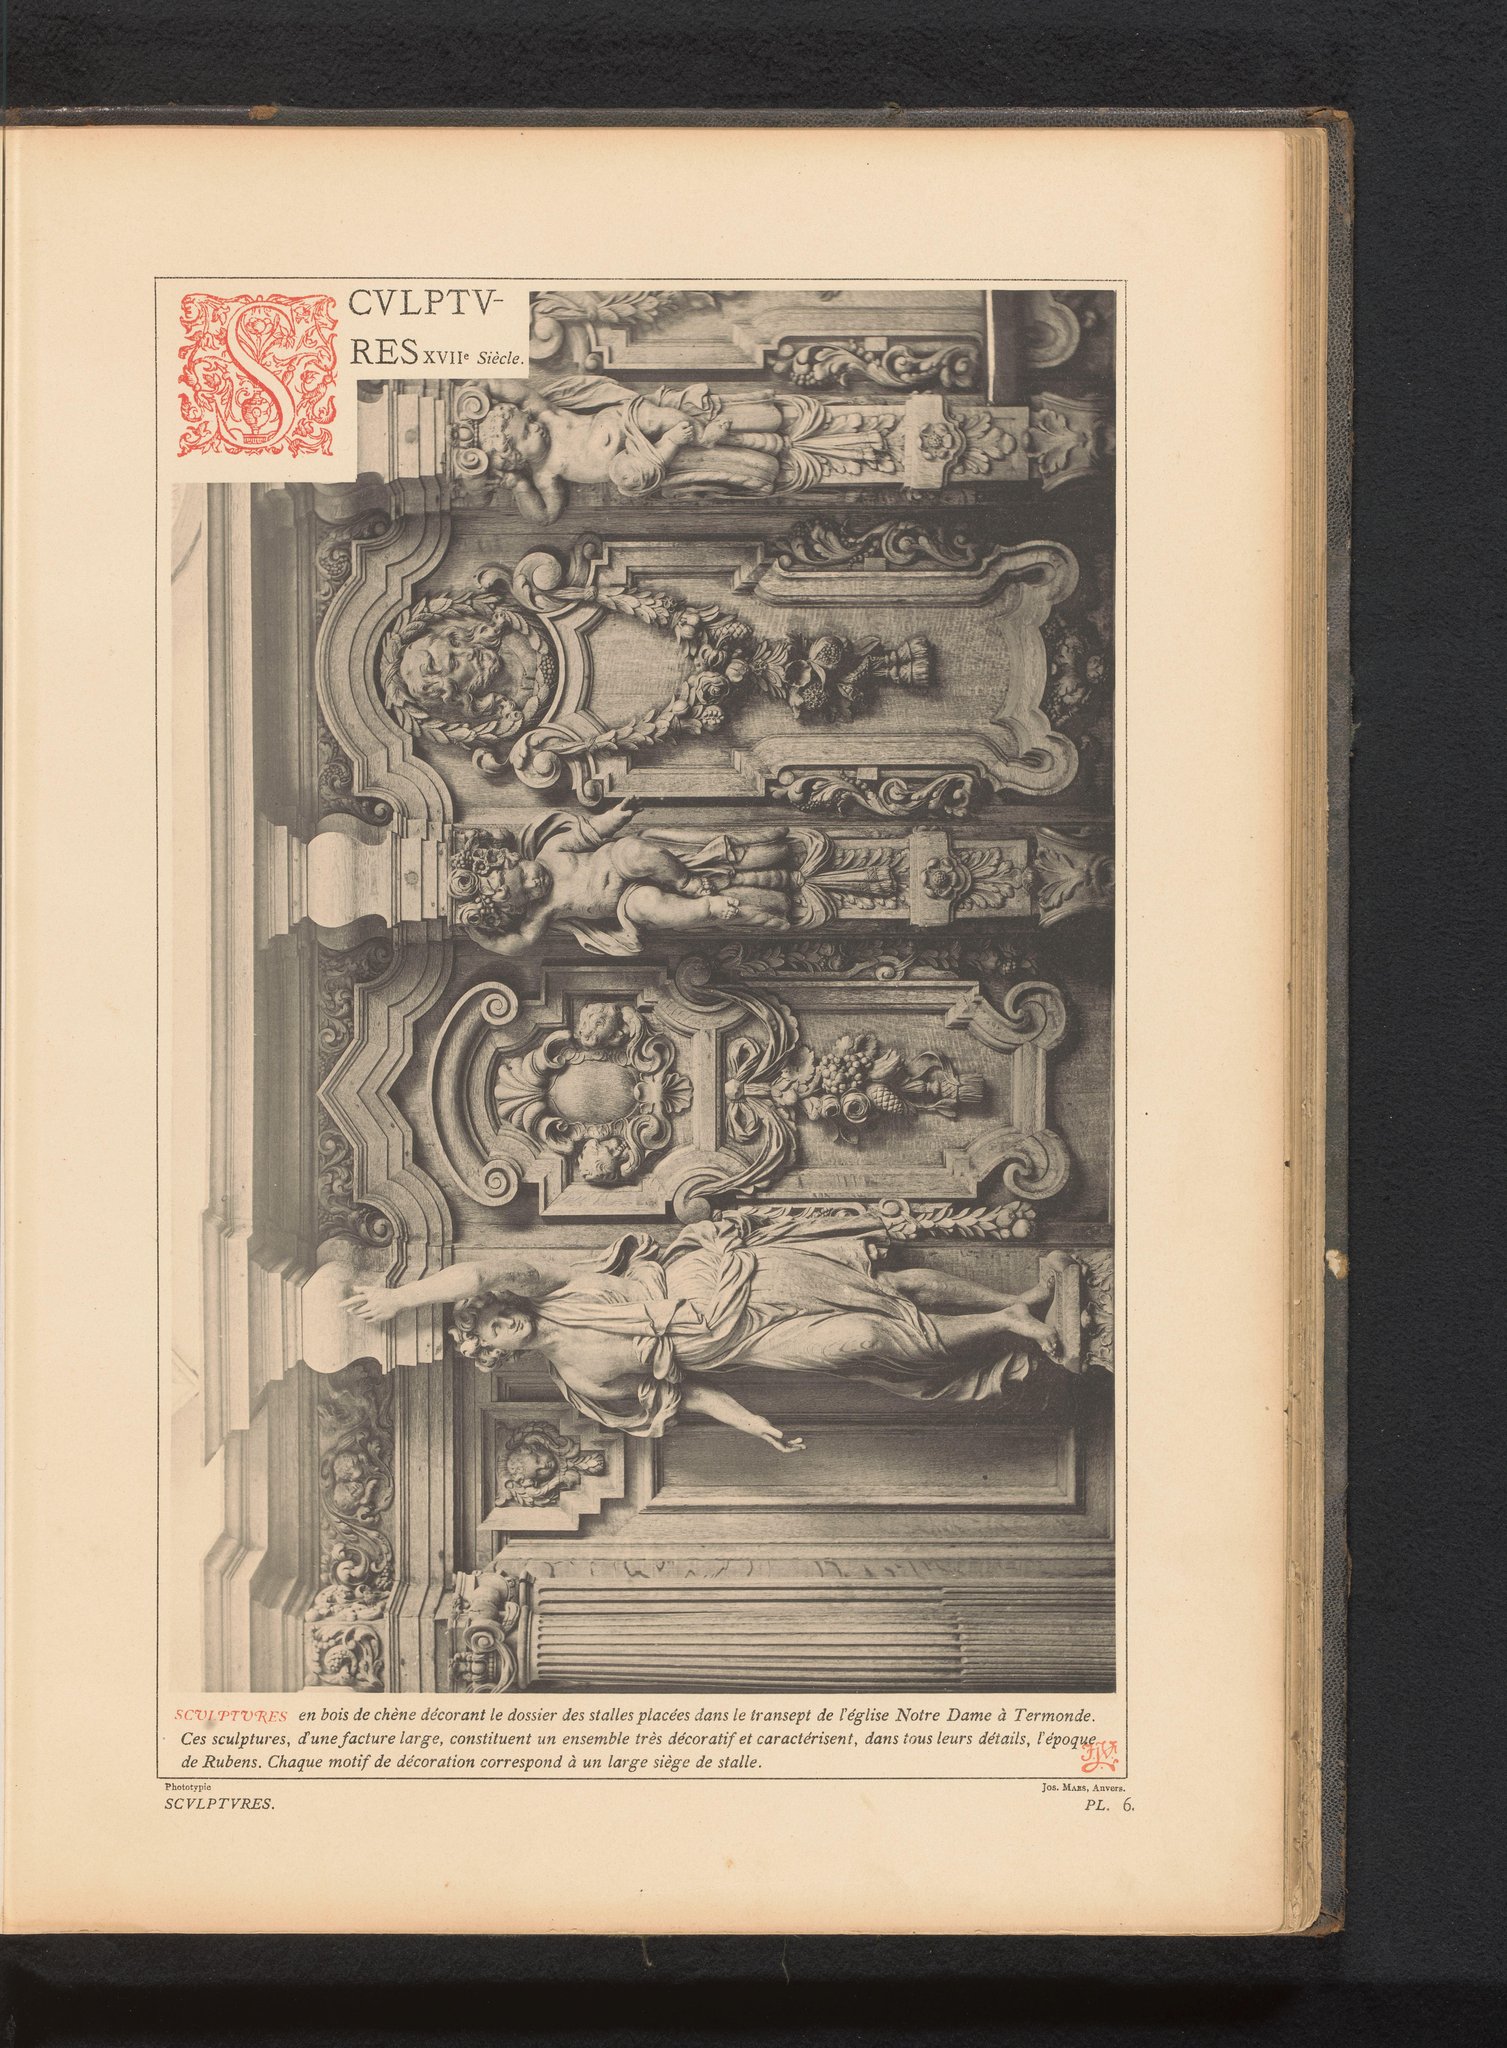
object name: photomechanical print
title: Sculptures XVIIe, Siècle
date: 1881-1889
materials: paper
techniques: photograph, photolithography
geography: dendermonde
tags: sculpture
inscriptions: inscription: ‘SCULPTURES en bois (...)’, monogram: ‘JJvY’, inscription: ‘SCULPTURES. PL. 6.’